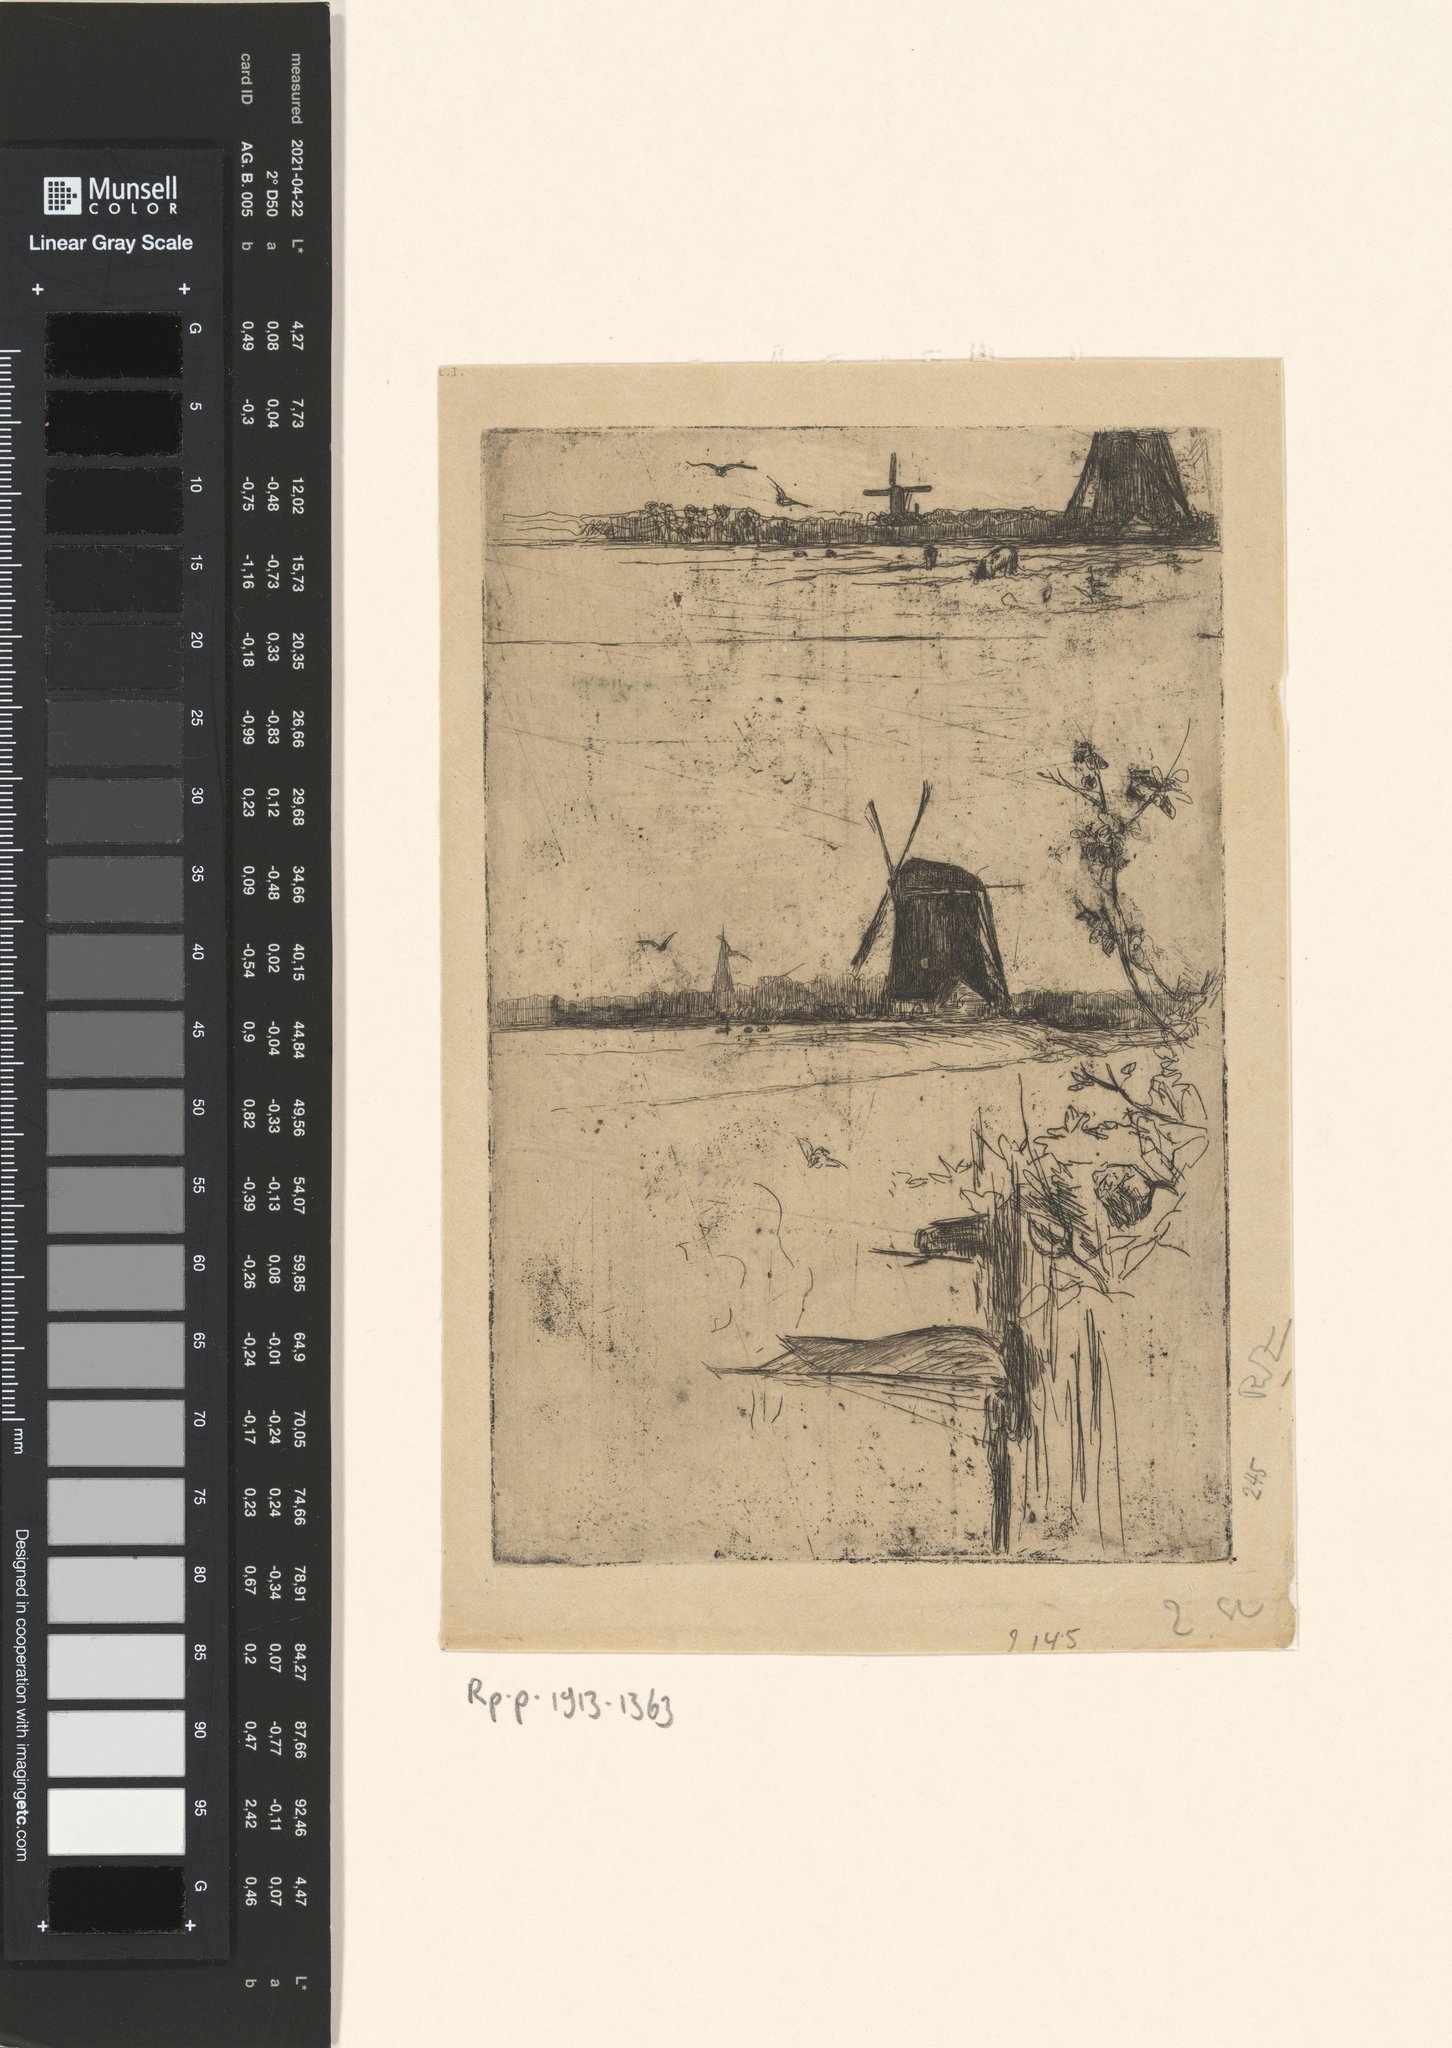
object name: print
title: Croquis de moulins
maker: philip zilcken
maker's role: draughtsman, painter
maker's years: 1857-1930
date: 1890-1913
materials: paper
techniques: drypoint, etching, intaglio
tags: sailing-ship, sailing-boat, windmill in landscape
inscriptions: collector's mark: Lugt 2228